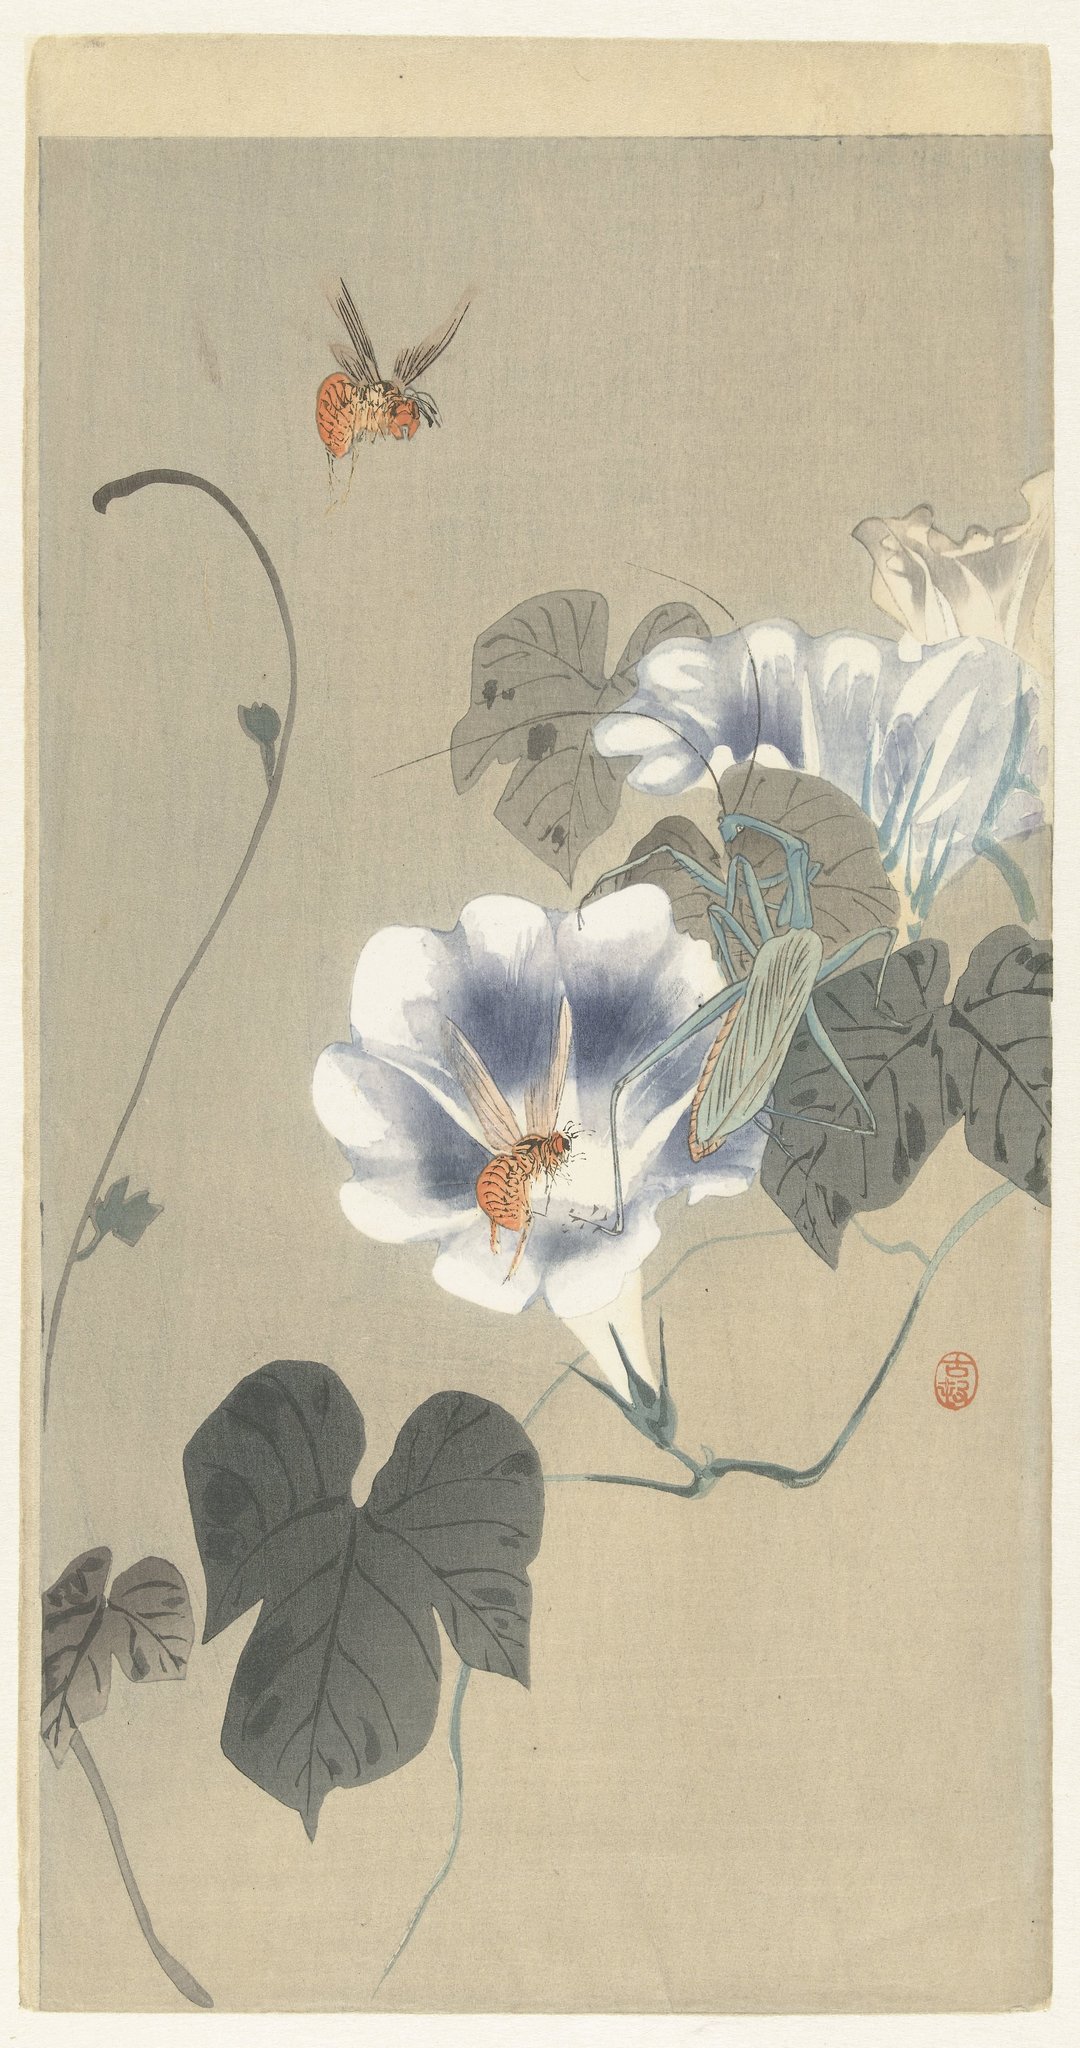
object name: print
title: Insecten bij winde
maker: ohara koson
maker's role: print maker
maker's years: 1877-1945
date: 1900-1930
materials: paper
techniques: woodcut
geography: tokyo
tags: flowers, insects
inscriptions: collector's mark: Lugt 2228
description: Bloeiende winde met bidsprinkhaan en twee oranje bijen.